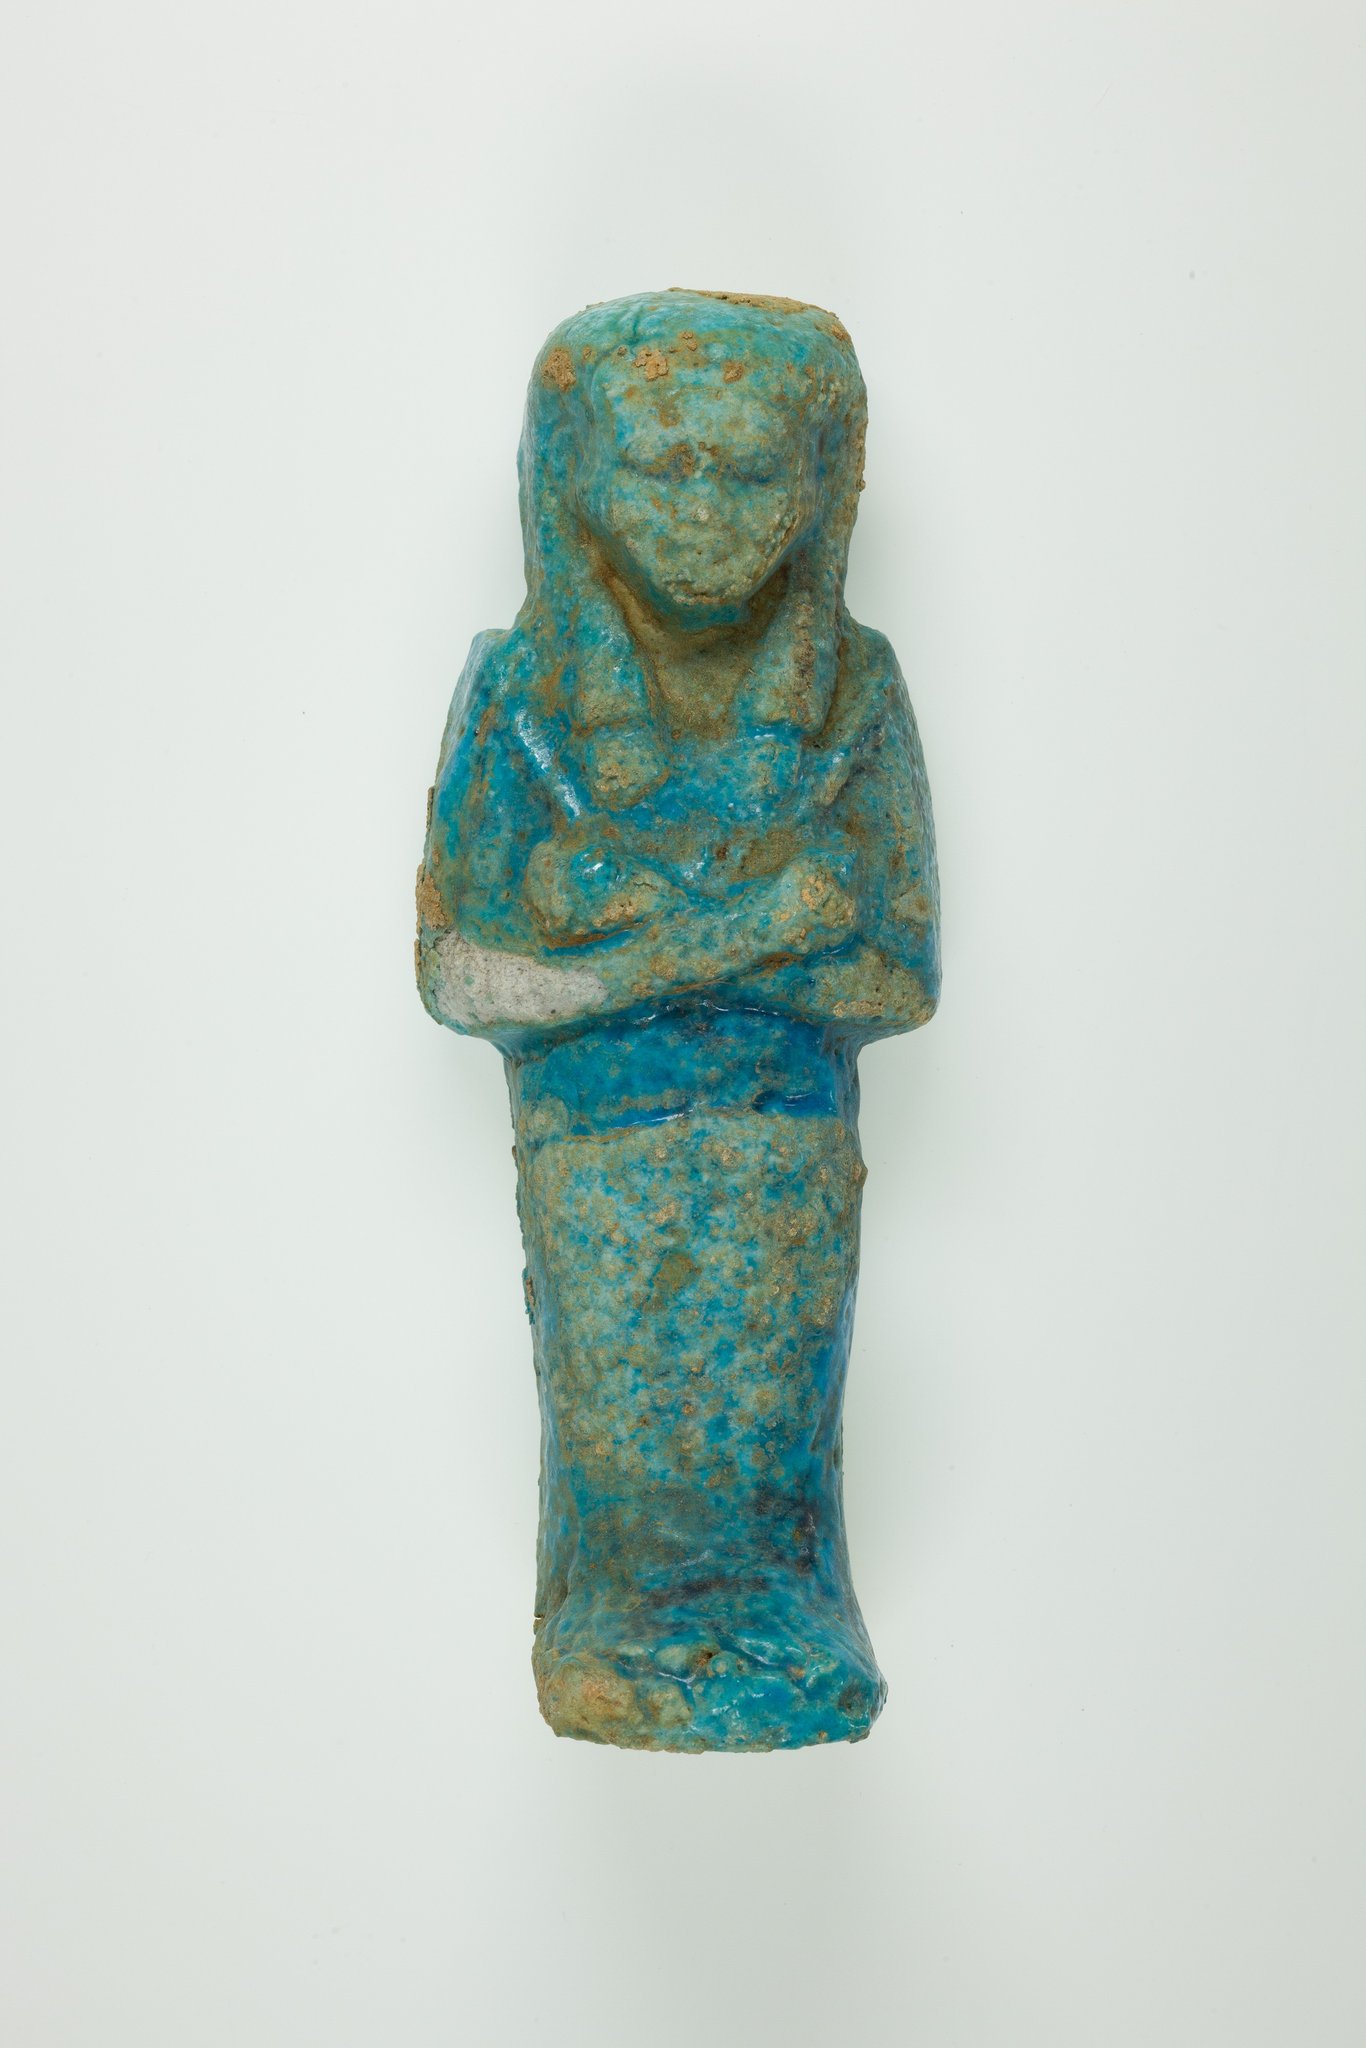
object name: worker shabti, henettawy c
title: Worker Shabti of Henettawy (C), Daughter of Isetemkheb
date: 990-970 BCE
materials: faience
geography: egypt